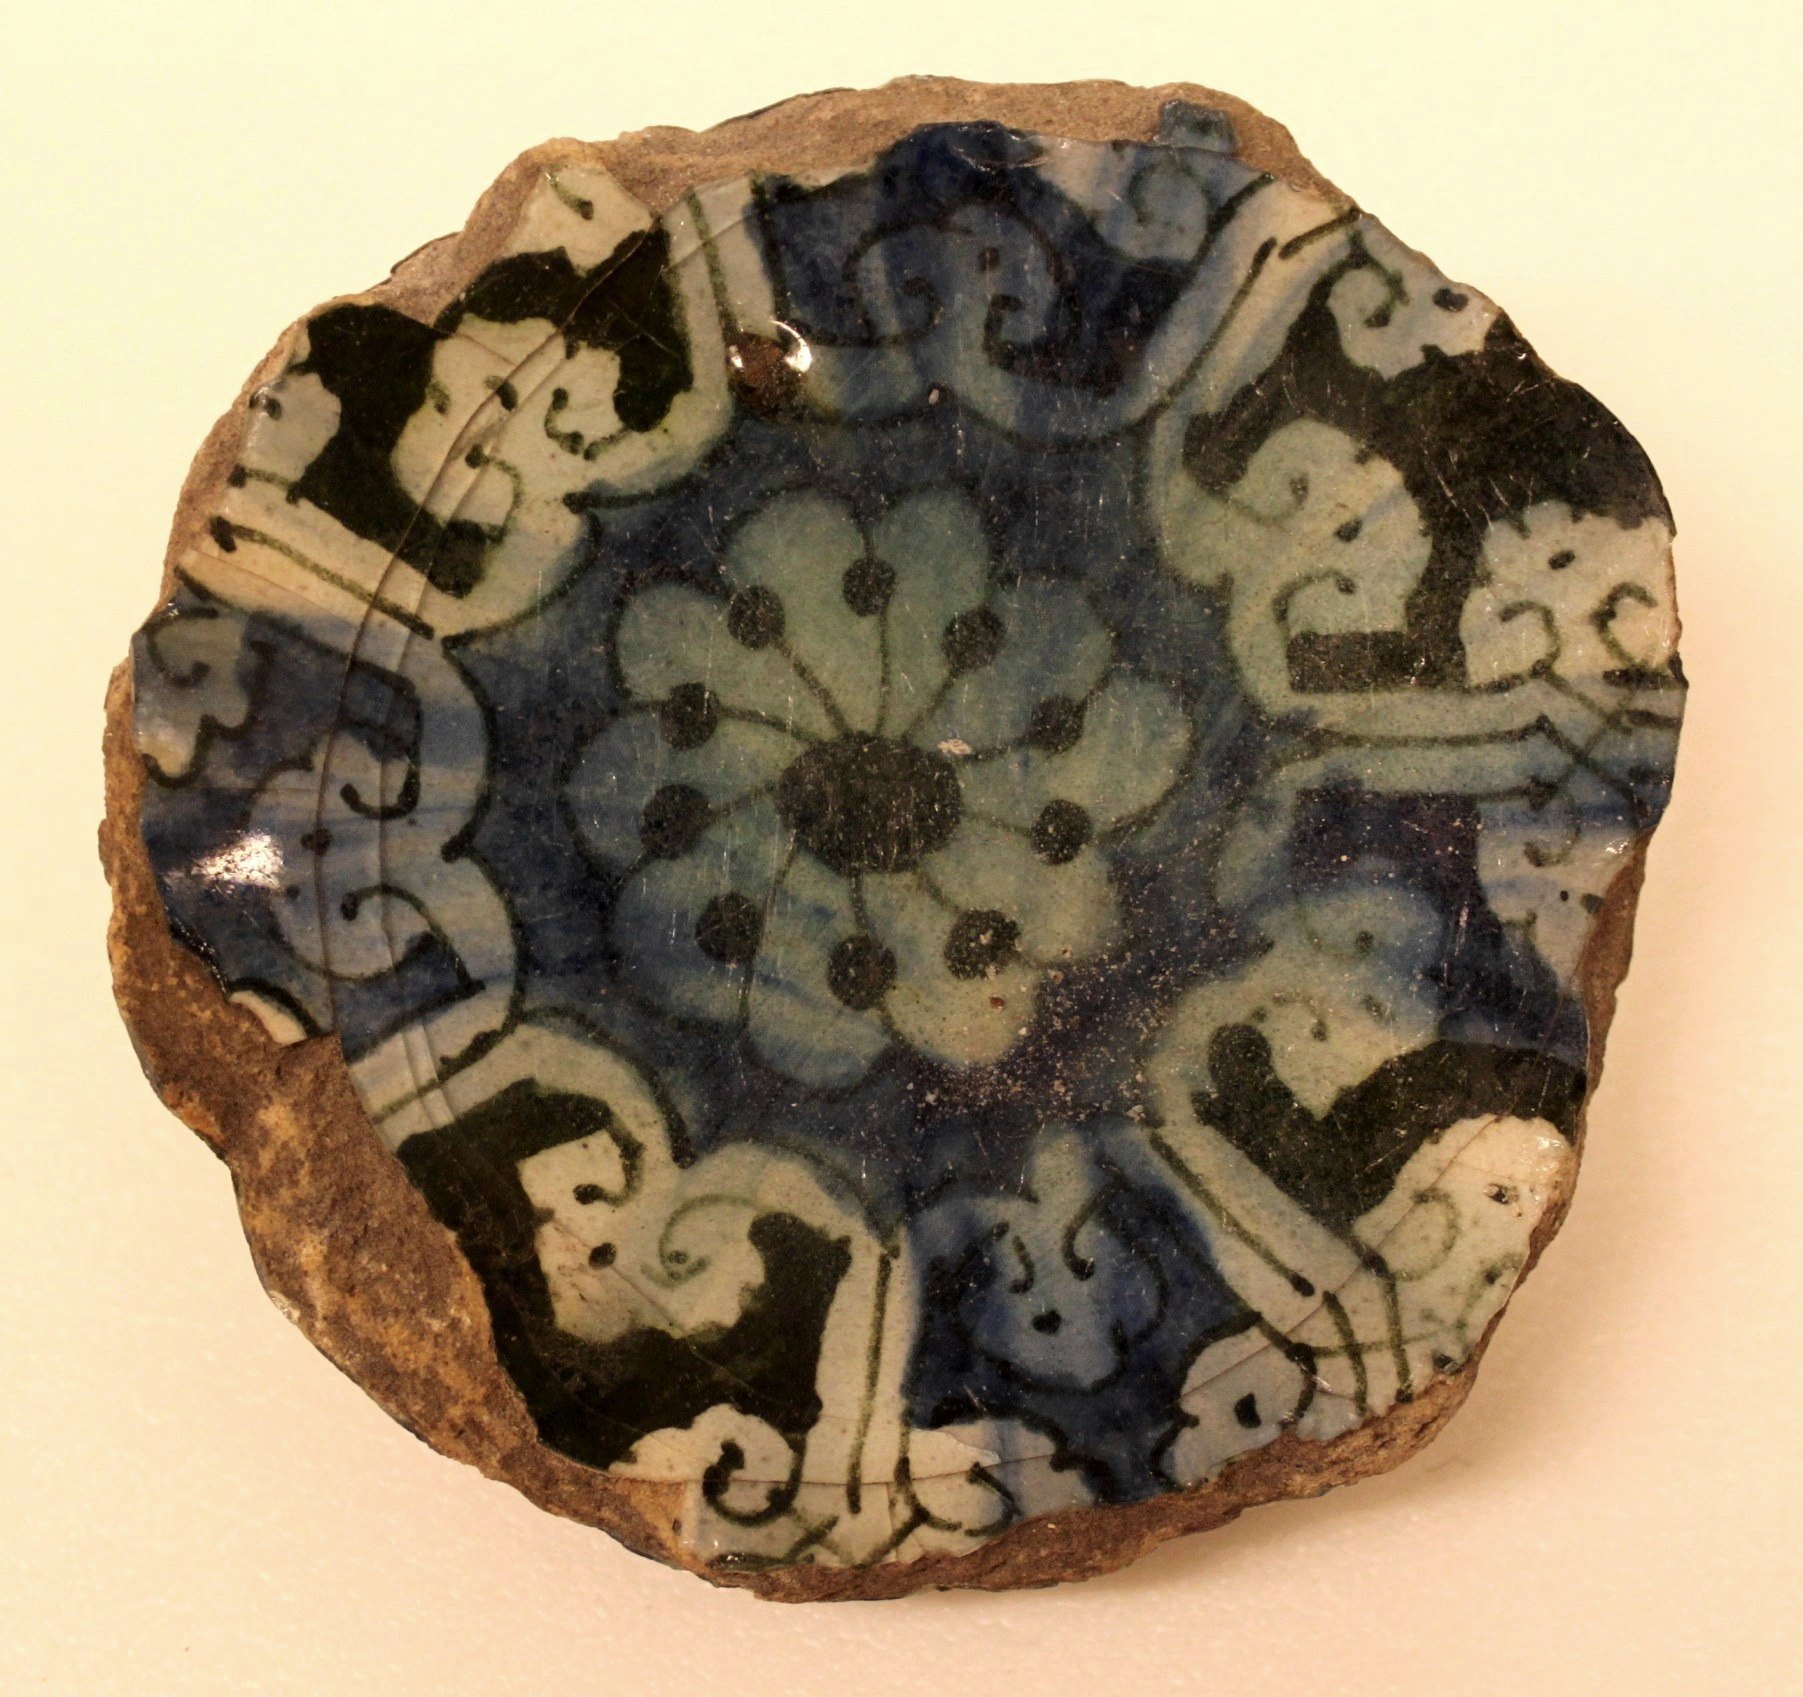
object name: fragment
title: Ceramic Fragment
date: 1201-1600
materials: glaze, stonepaste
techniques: painting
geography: egypt